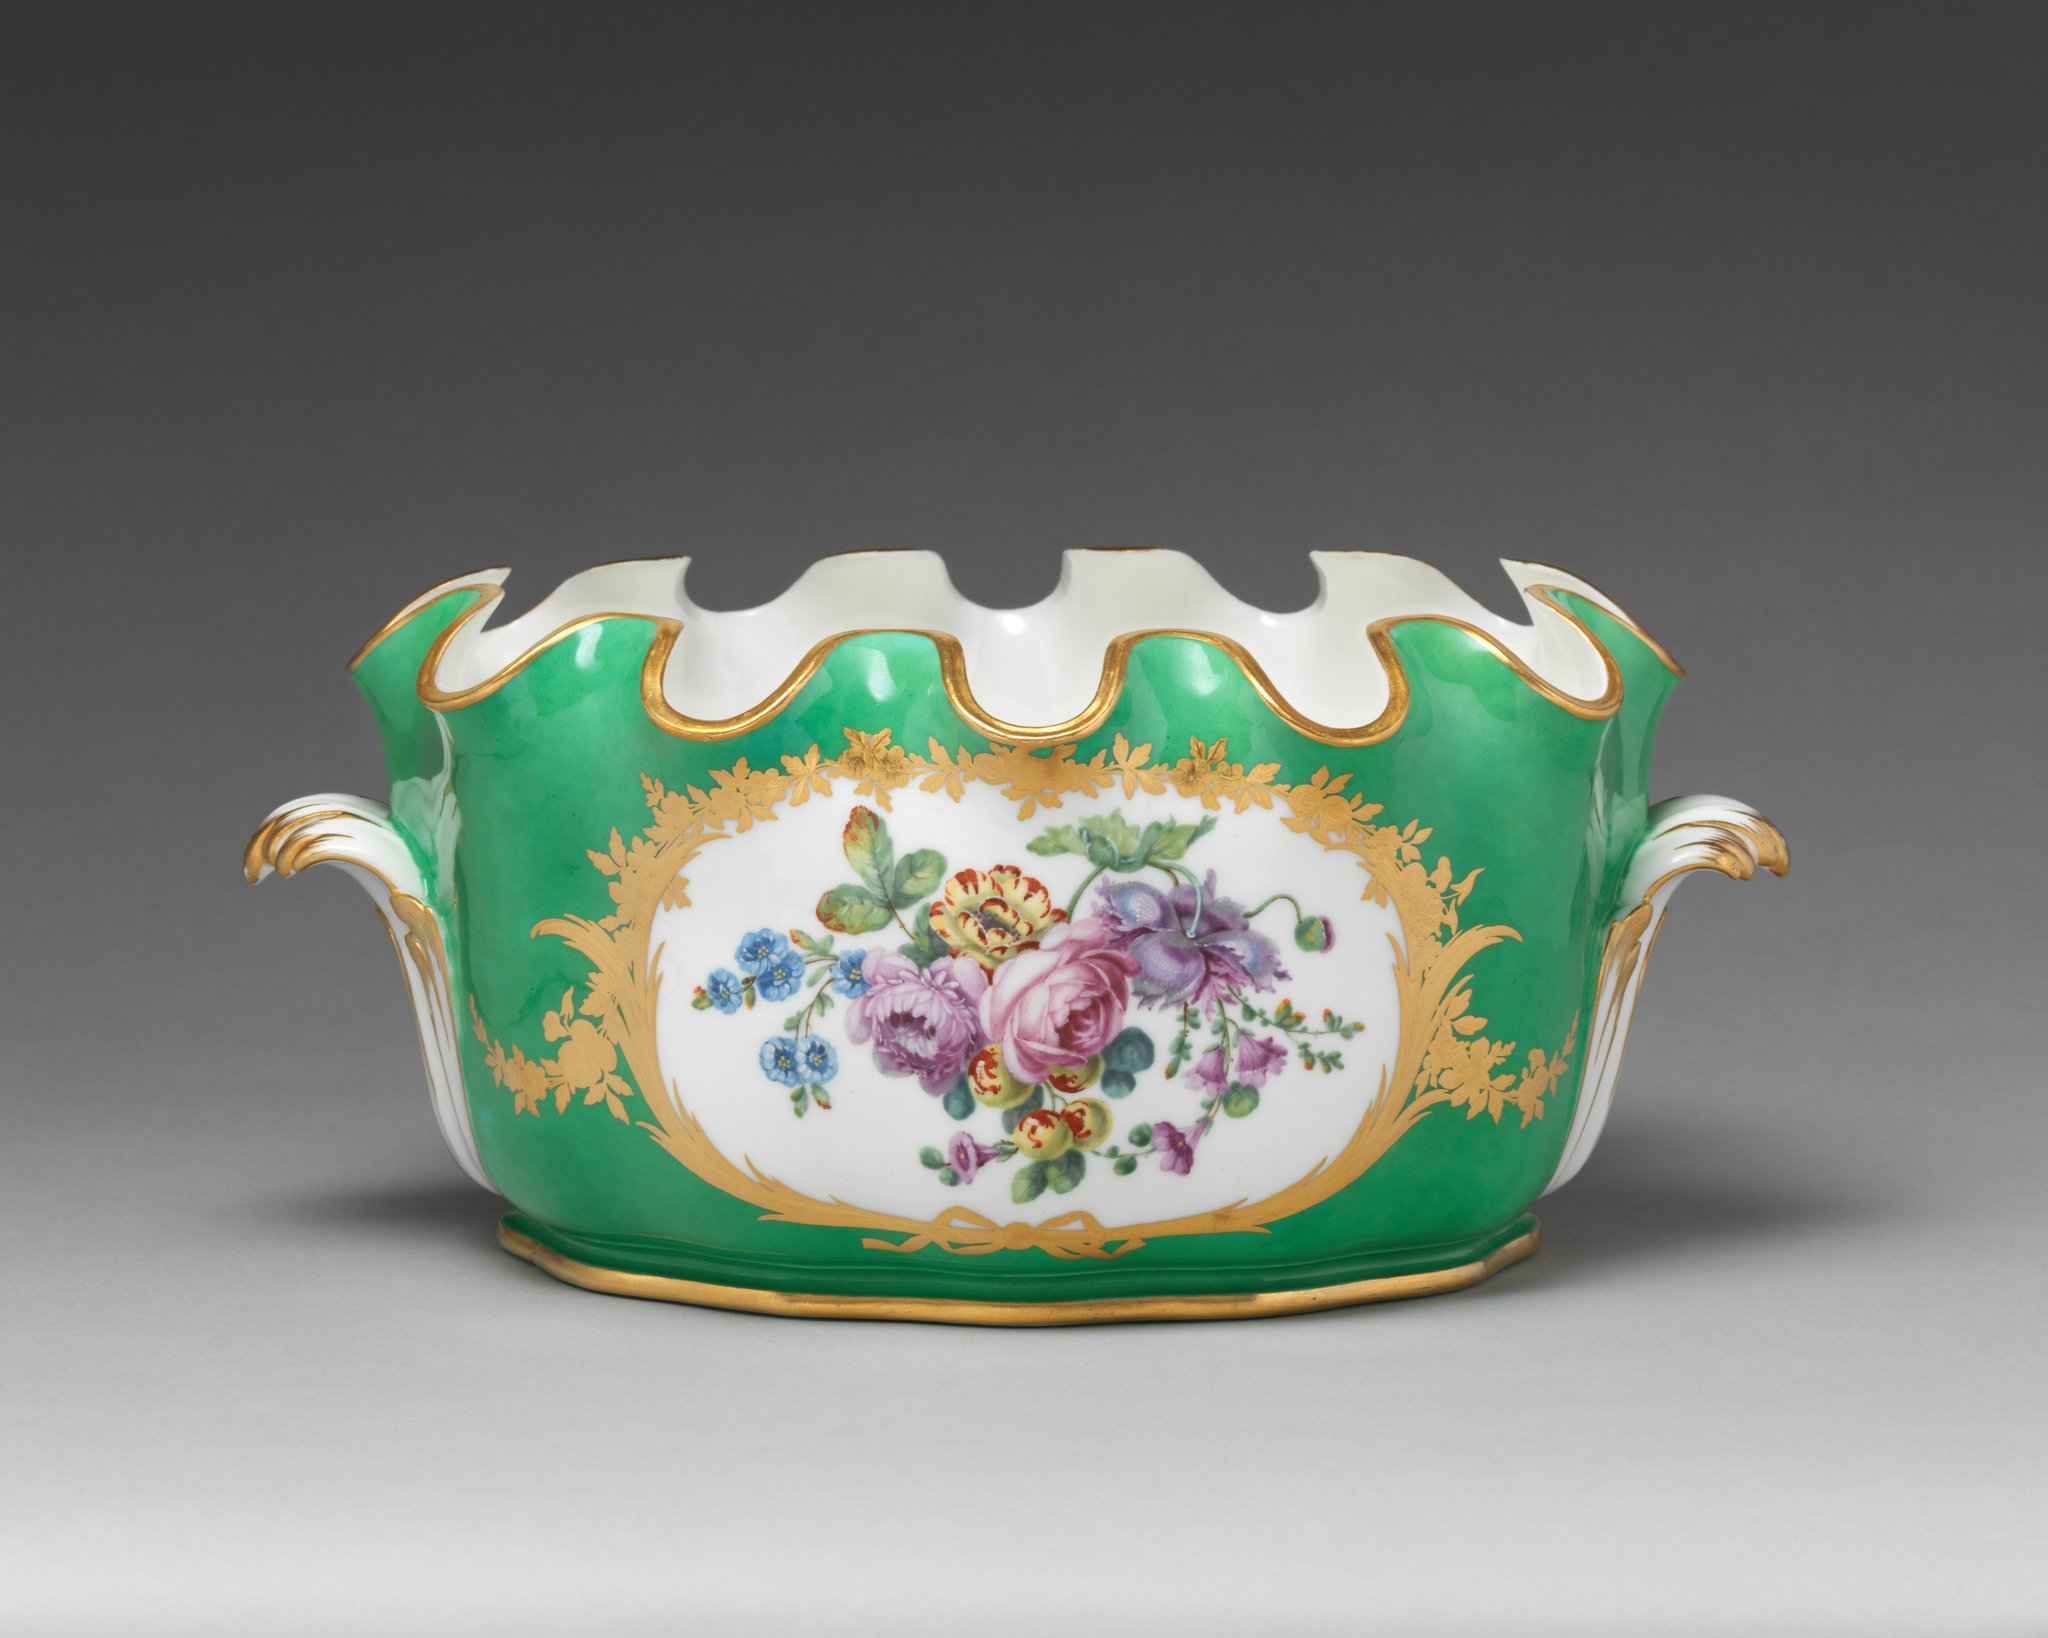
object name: monteith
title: Monteith (seau crennelé) (one of two) (part of a service)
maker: sèvres manufactory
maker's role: manufactory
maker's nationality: french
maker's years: 1740-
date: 1770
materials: soft paste porcelain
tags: flowers